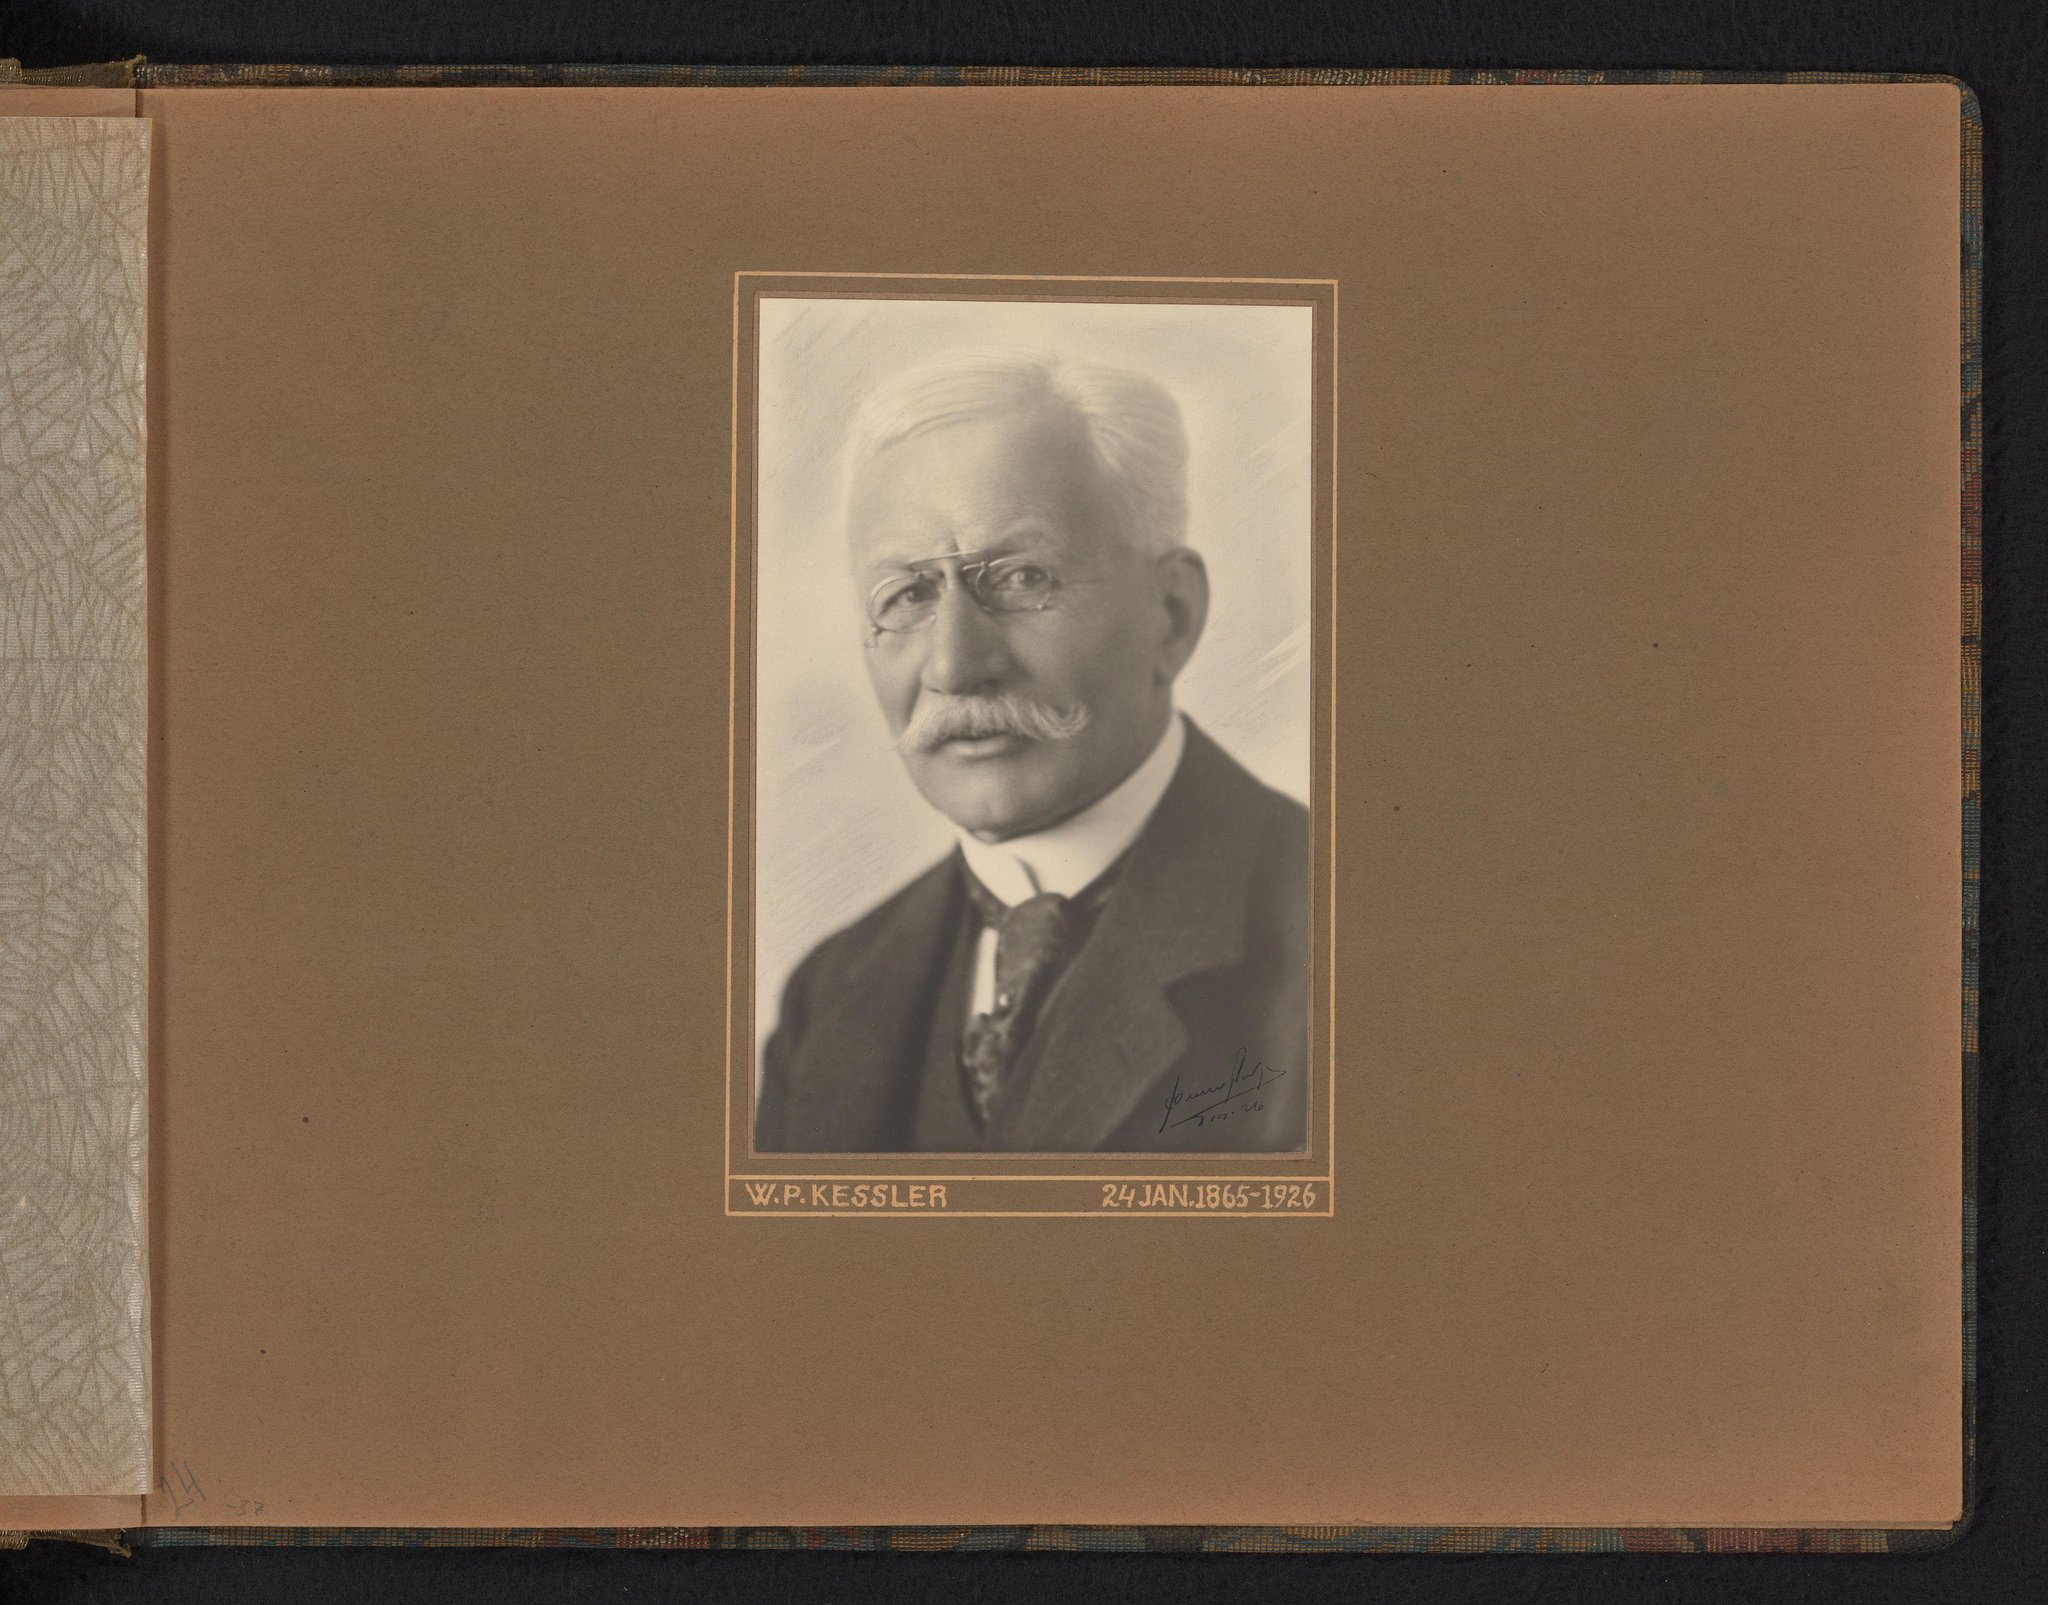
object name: photograph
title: W.P. Kessler 24 jan. 1865-1926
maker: Anonymous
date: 1920-1926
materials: paper, cardboard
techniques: gelatin silver print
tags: historical persons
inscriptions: signature: ‘[...]’